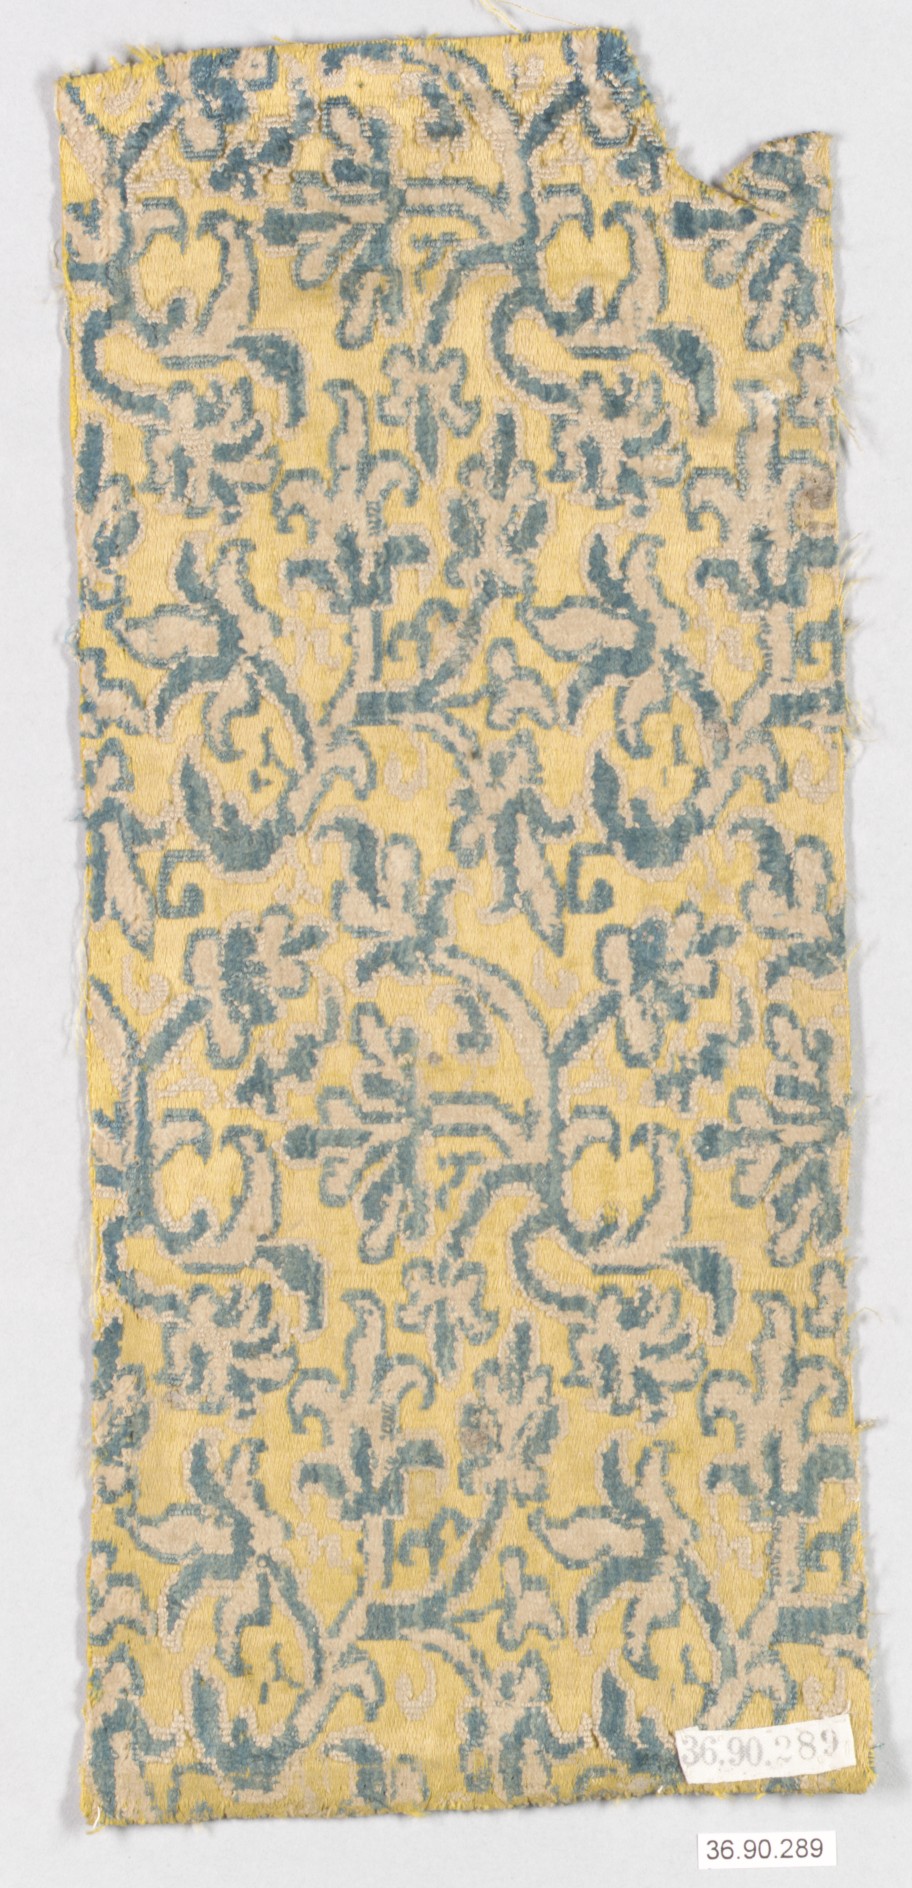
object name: piece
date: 1501-1700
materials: silk